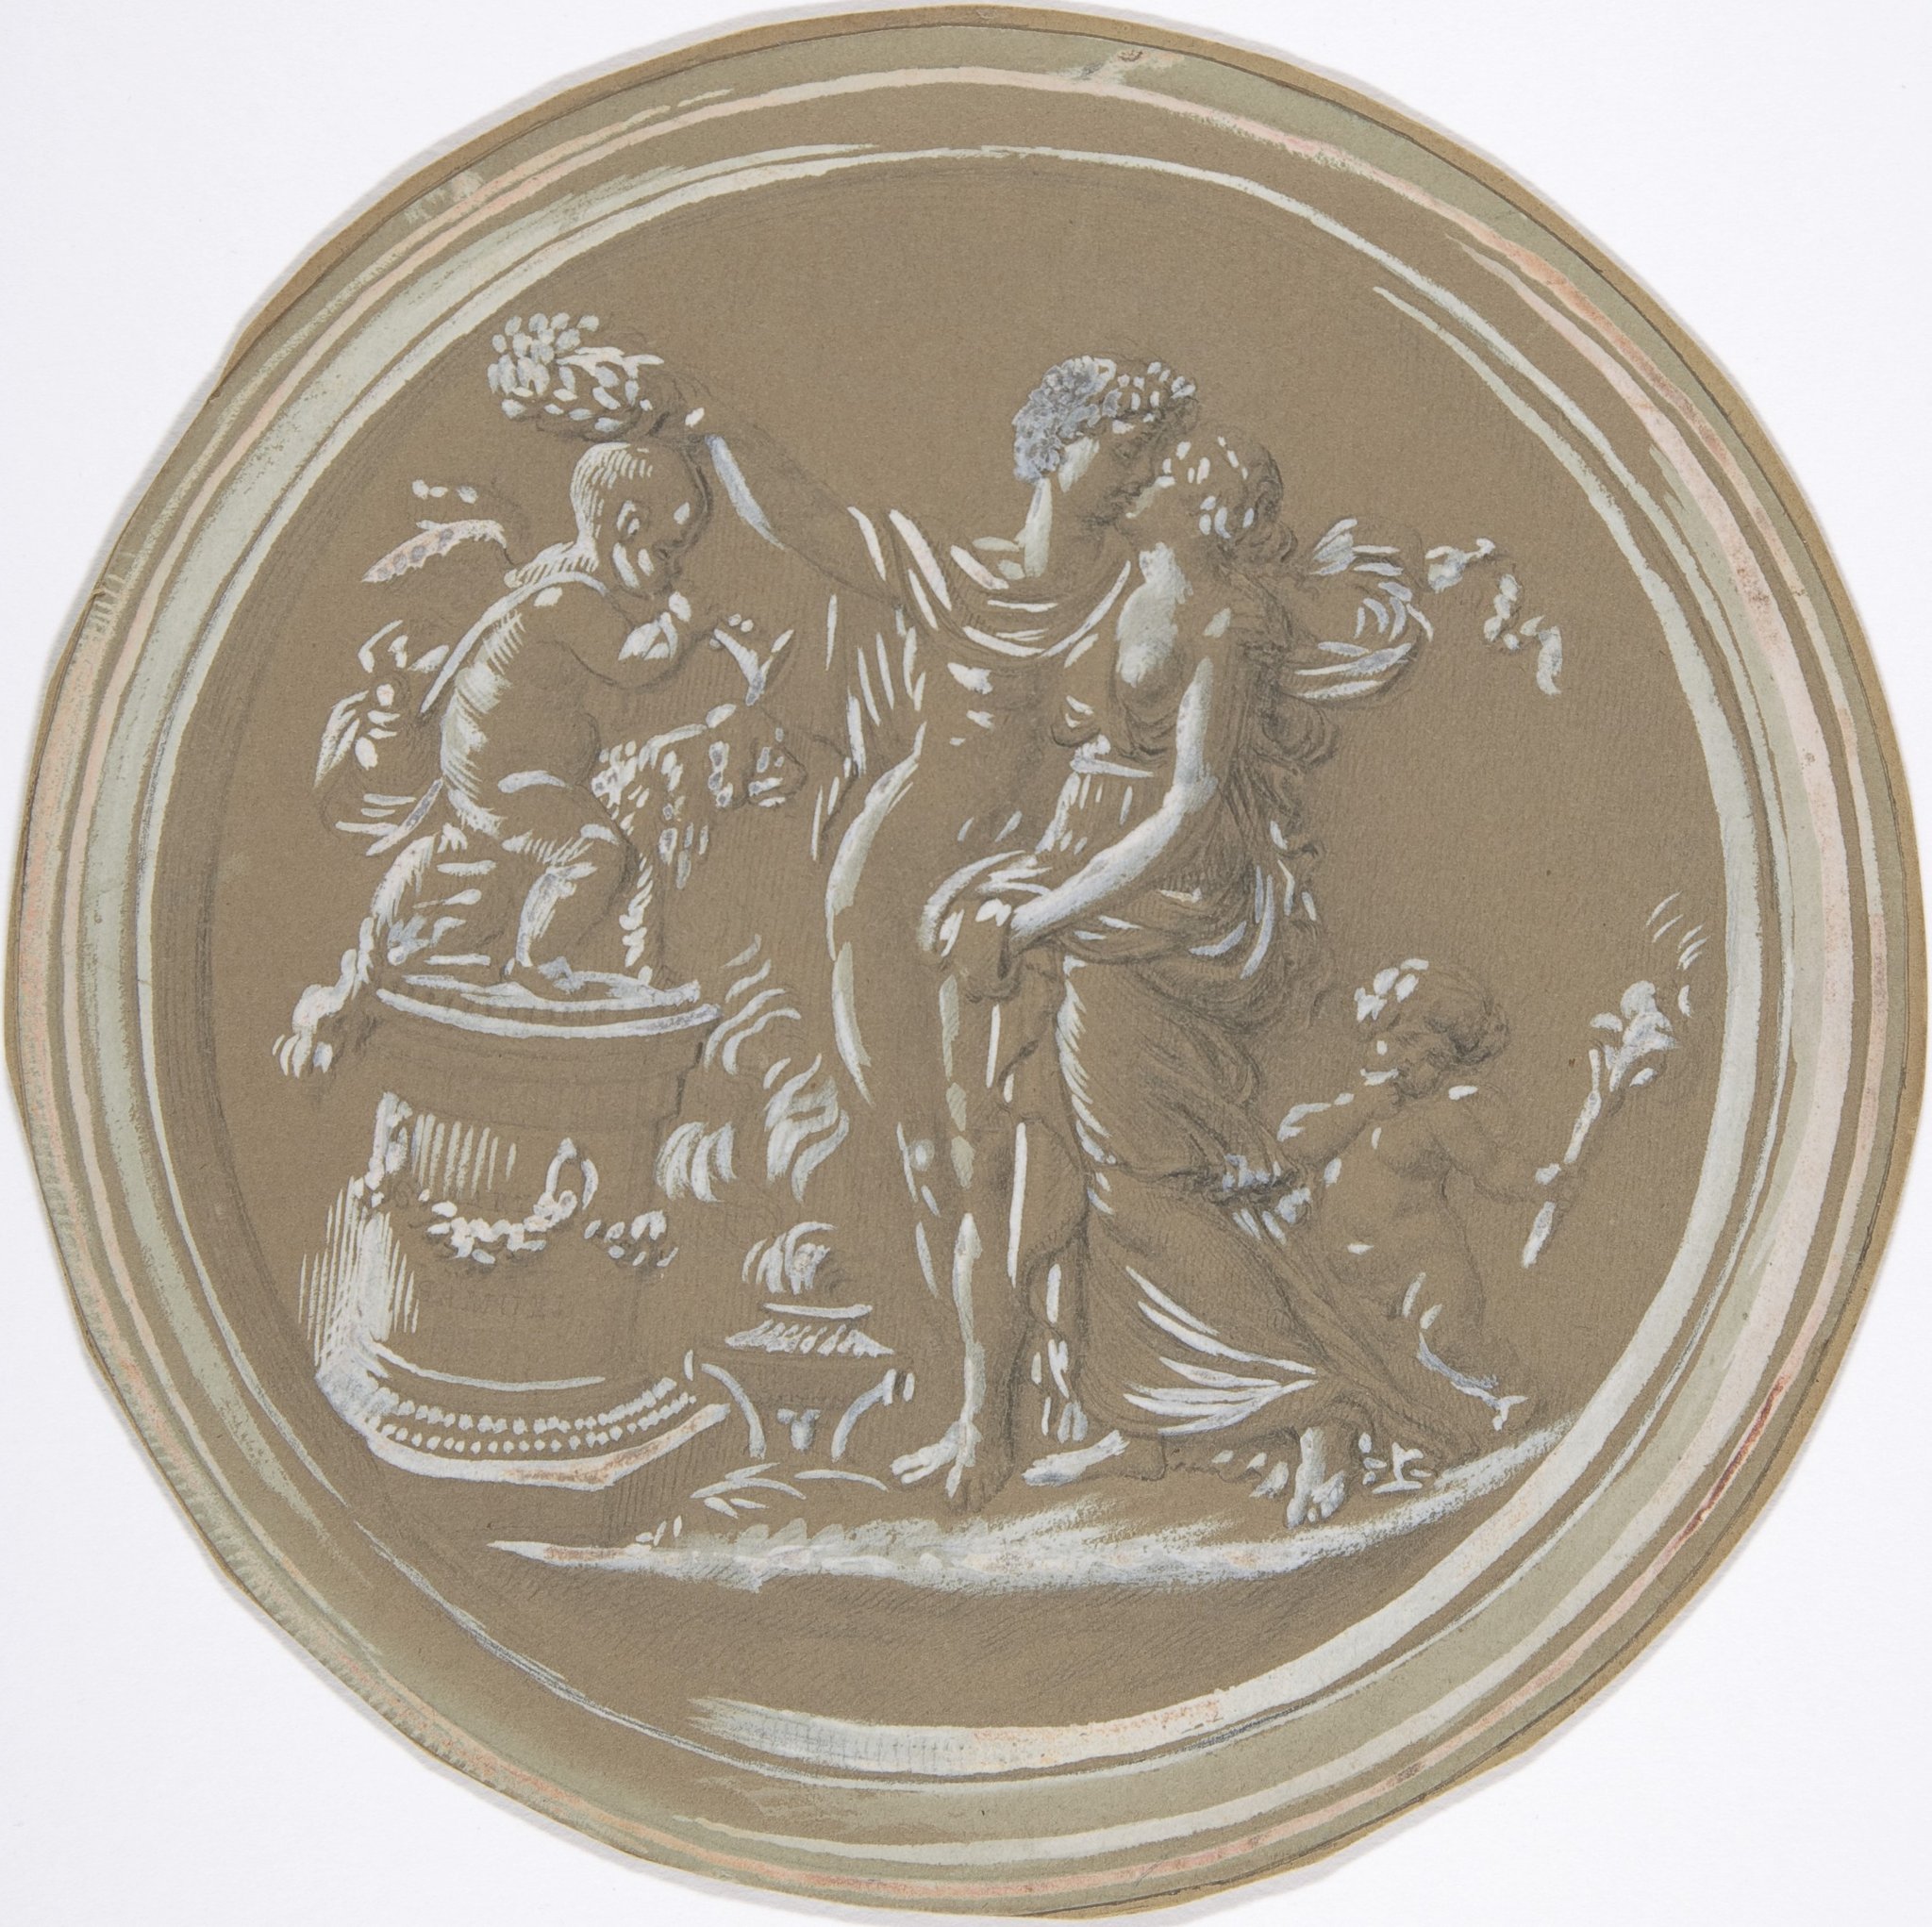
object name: drawing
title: Design for Tomb Monument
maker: anonymous, french, 18th century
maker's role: artist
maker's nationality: french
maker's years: 1700-1800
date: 1701-1800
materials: gouache, graphite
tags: men,women,putti